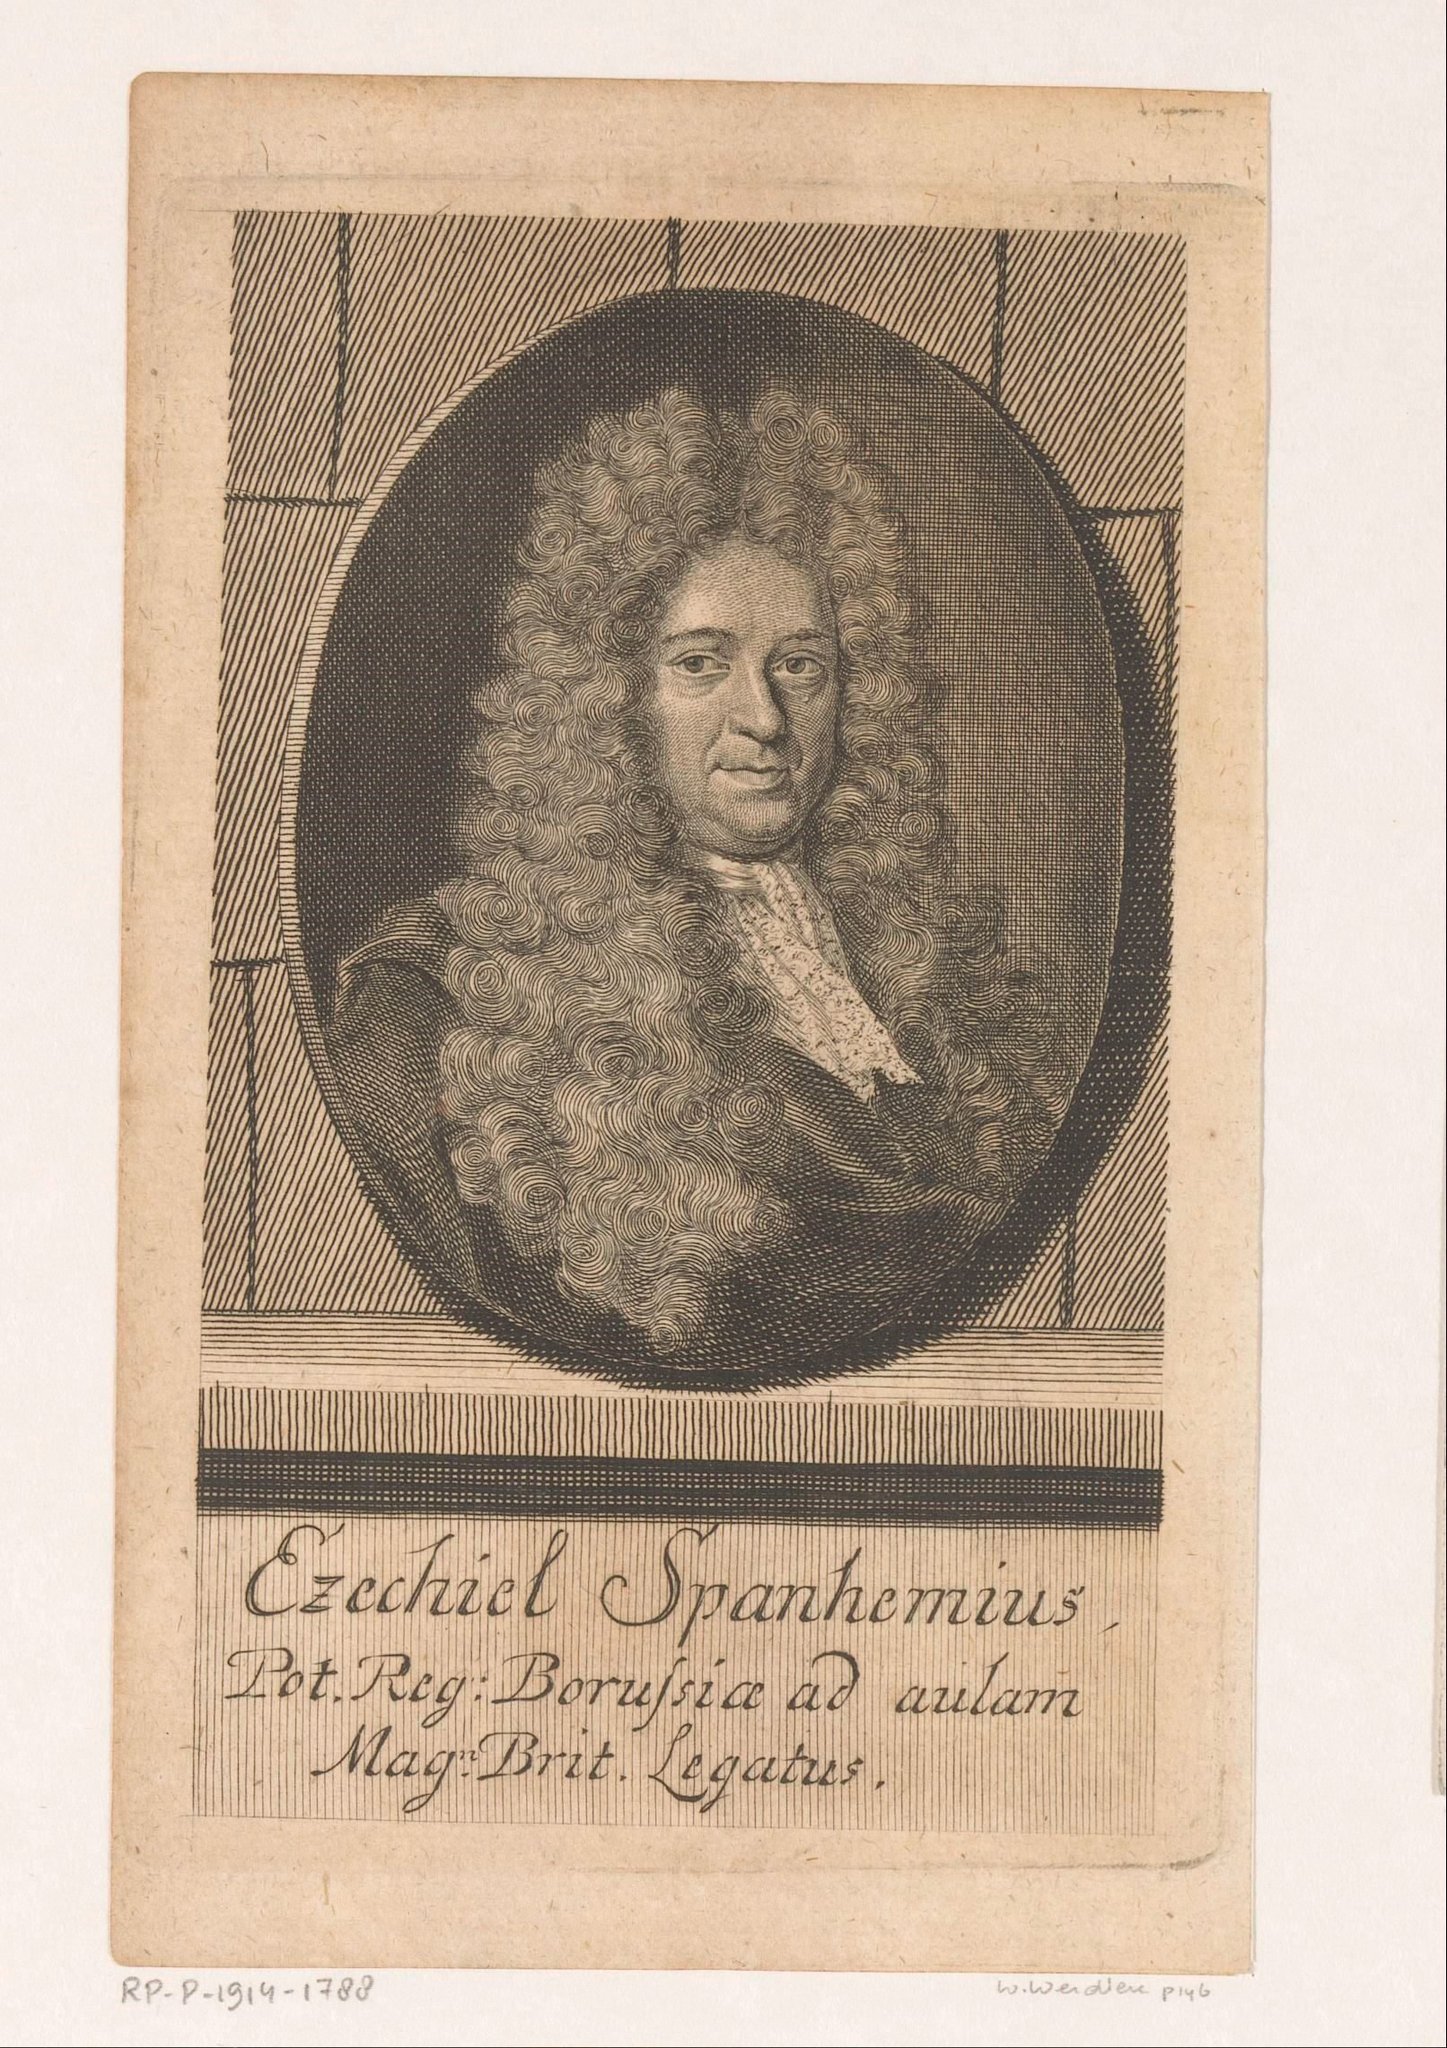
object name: print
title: Portret van Ezechiel Spanheim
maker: martin bernigeroth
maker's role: print maker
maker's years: 1670-1733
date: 1717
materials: paper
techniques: engraving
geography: leipzig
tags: london, historical persons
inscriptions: collector's mark: Lugt 2228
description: Prent ook gebruikt in: Deutsche Acta Eruditorum (...). dl. 48. Leipzig: Johann Gottlieb Gleditsch, 1717.